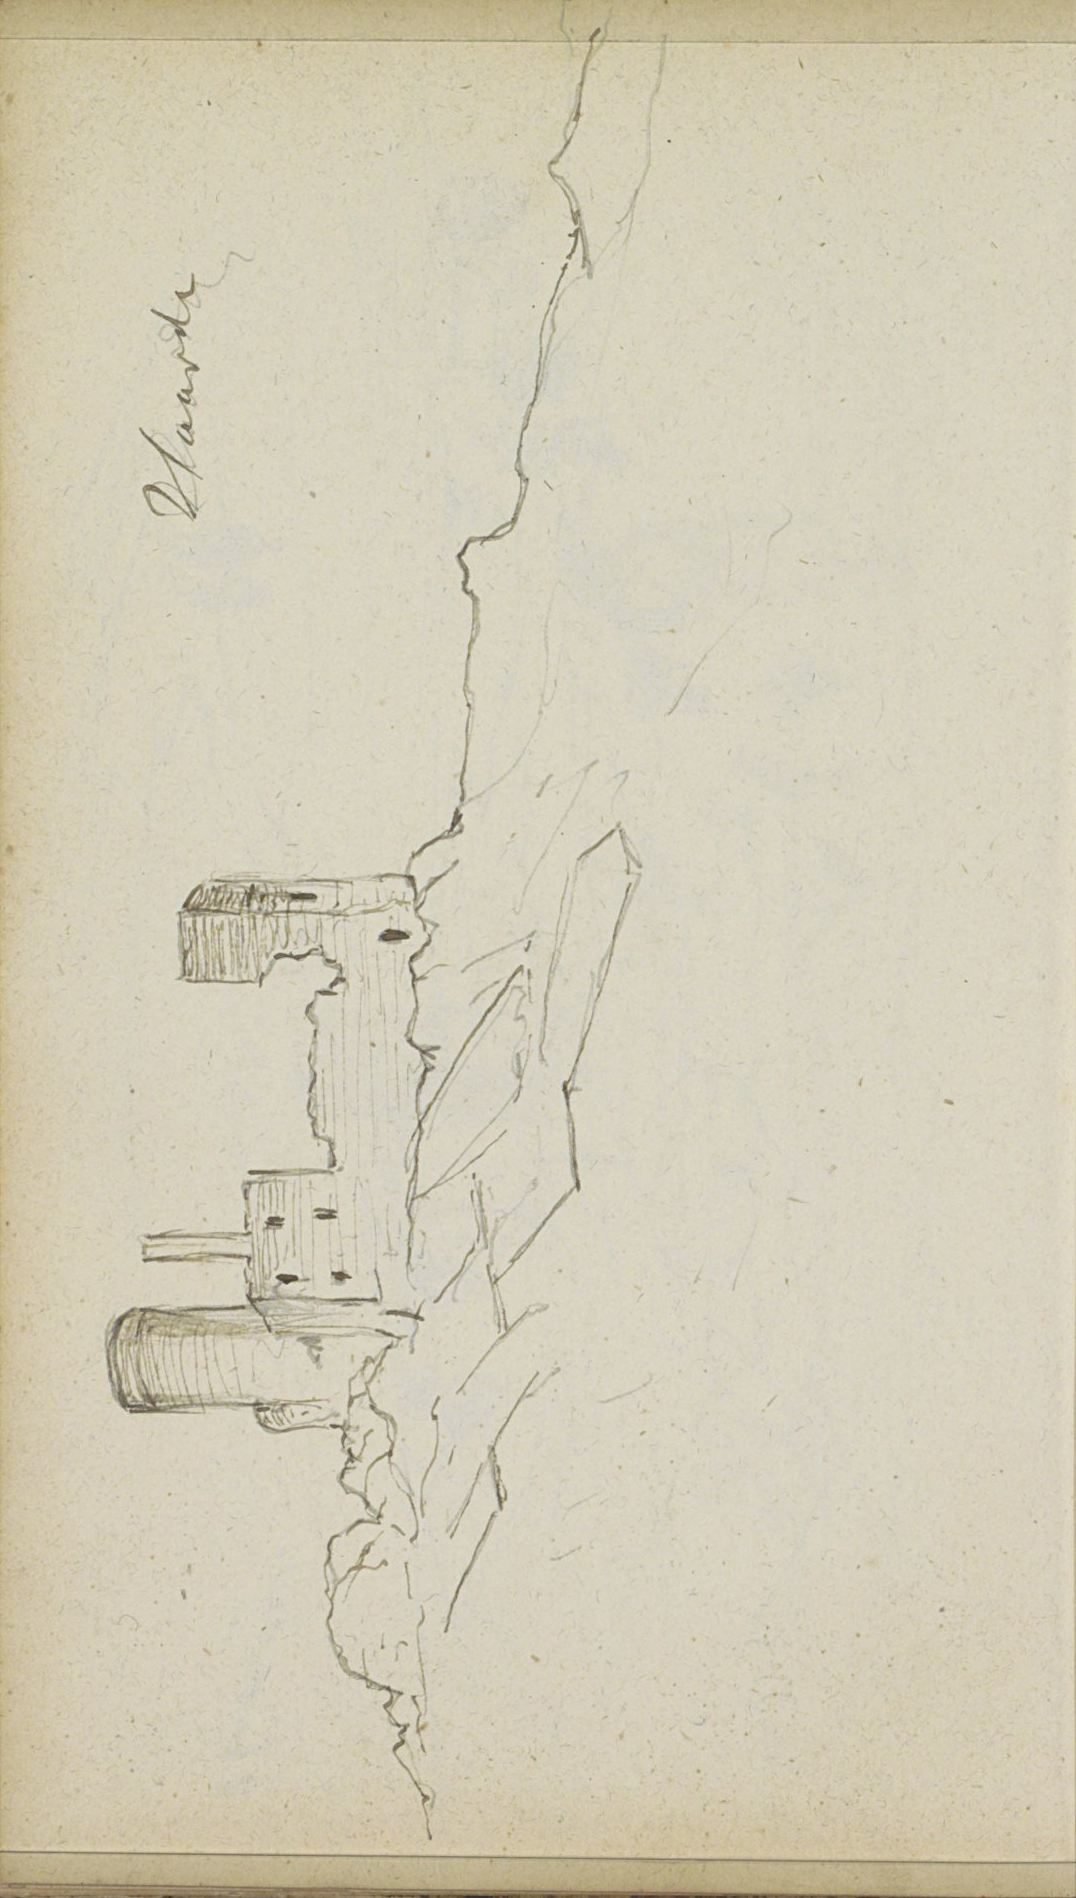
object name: sketchbook leaf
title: Slot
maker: johannes tavenraat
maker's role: draughtsman, painter, print maker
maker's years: 1809-1881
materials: ink, paper, pencil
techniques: pen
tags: castle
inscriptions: annotation: ‘[...]aarde.’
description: Blad 17 verso uit een schetsboek met 88 bladen.